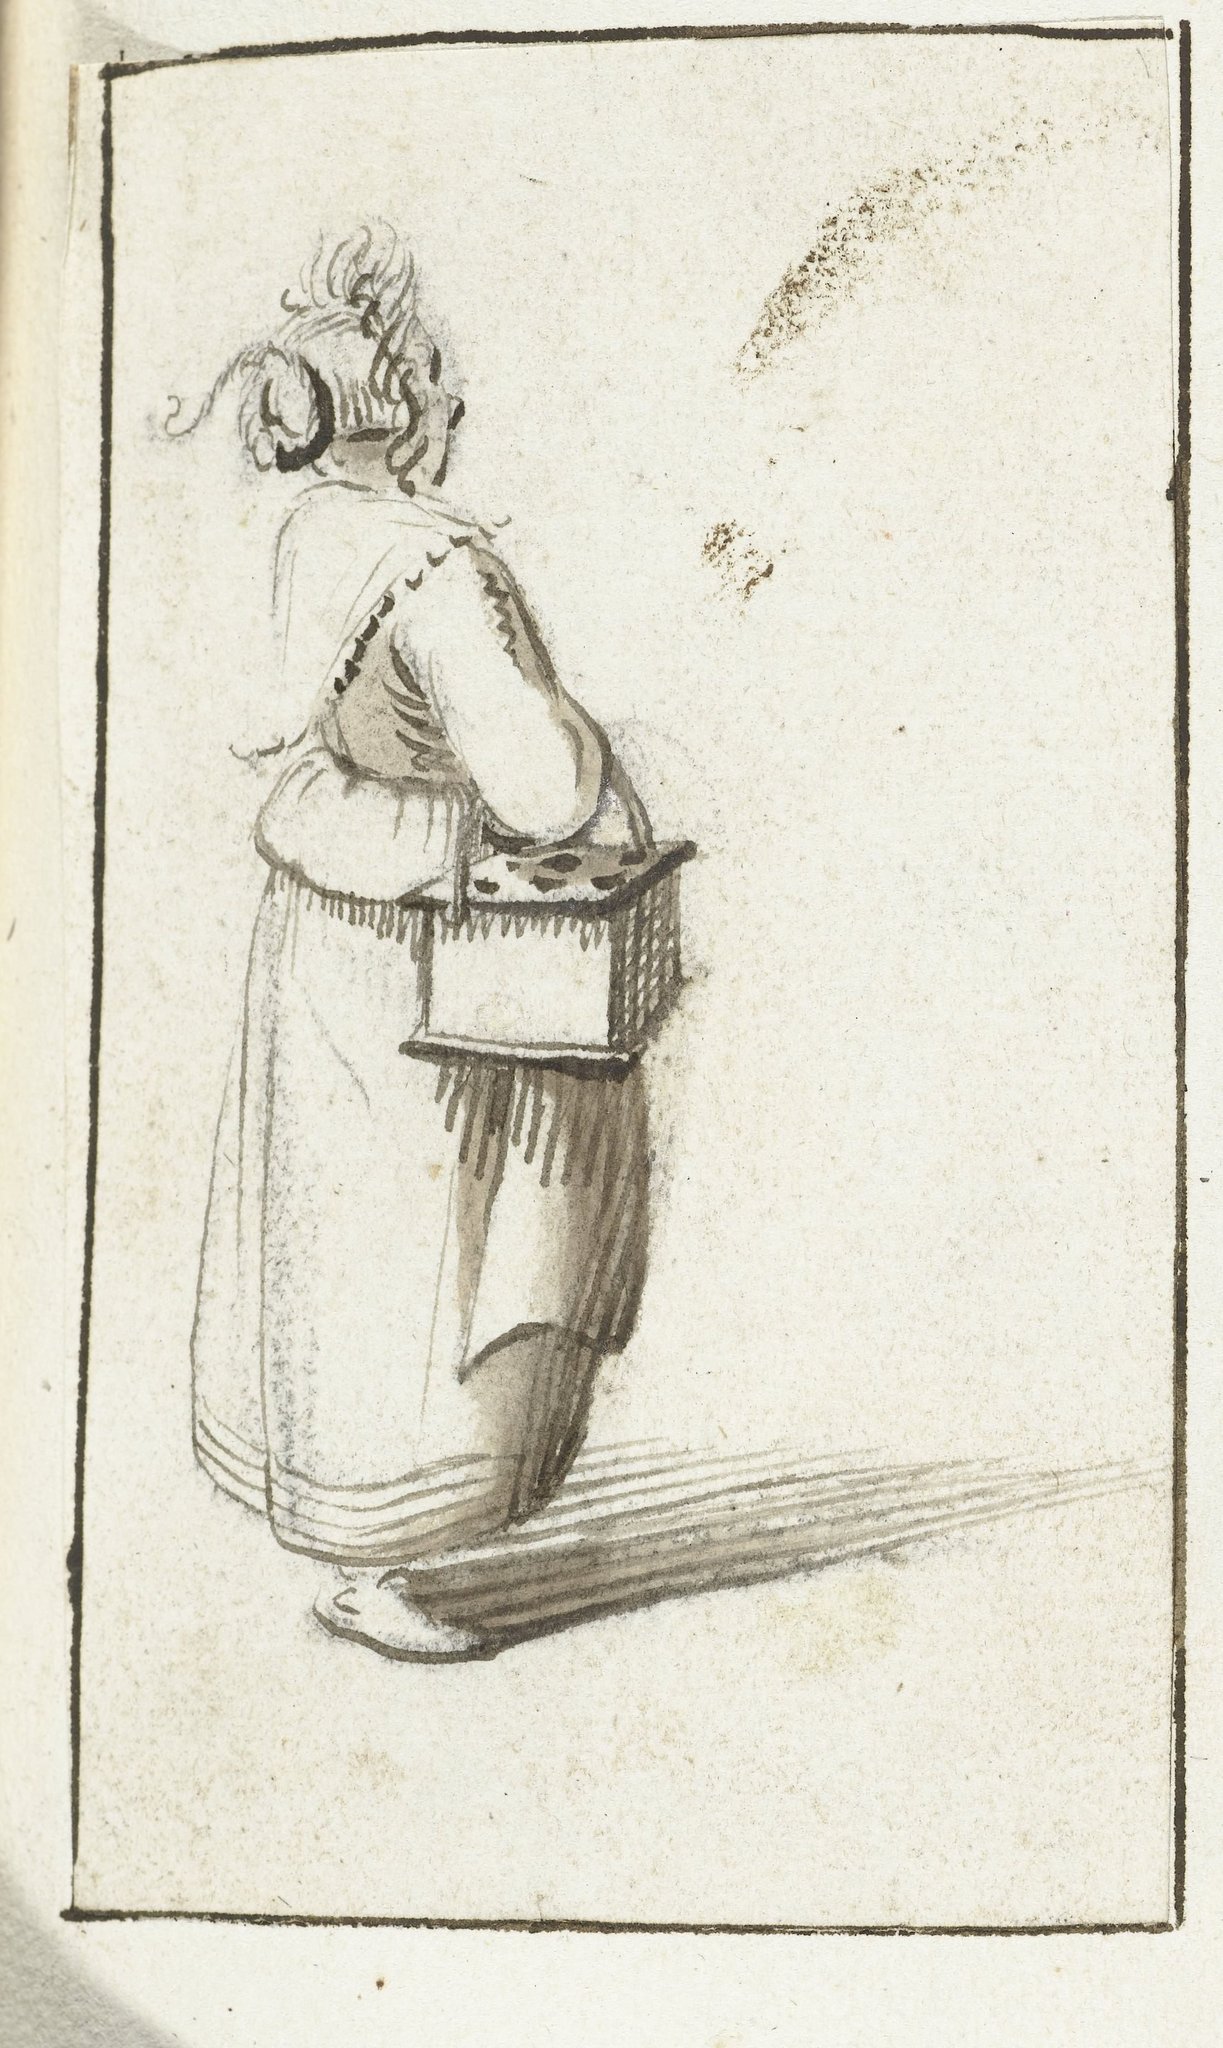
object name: drawing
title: Vrouw met een stoof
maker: harmen ter borch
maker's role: draughtsman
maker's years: 1638-1677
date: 1648-1677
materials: chalk, ink, paper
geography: zwolle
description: Tekening naast twee andere tekeningen in het Familie-plakboek geplakt.